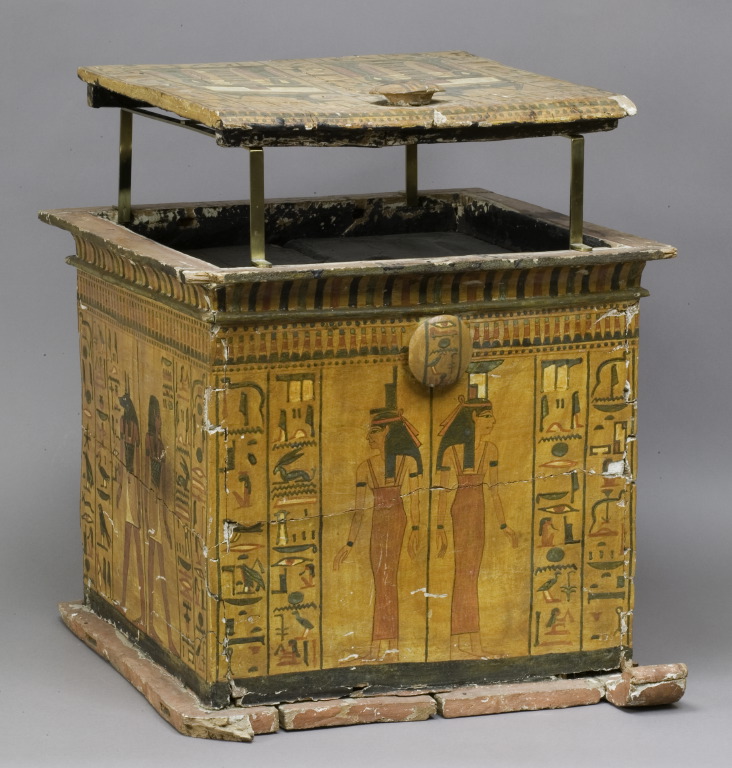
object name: canopic chest, khonsu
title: Canopic Chest of Khonsu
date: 1279-1213 BCE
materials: gesso, linen, paint, varnish, wood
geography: egypt